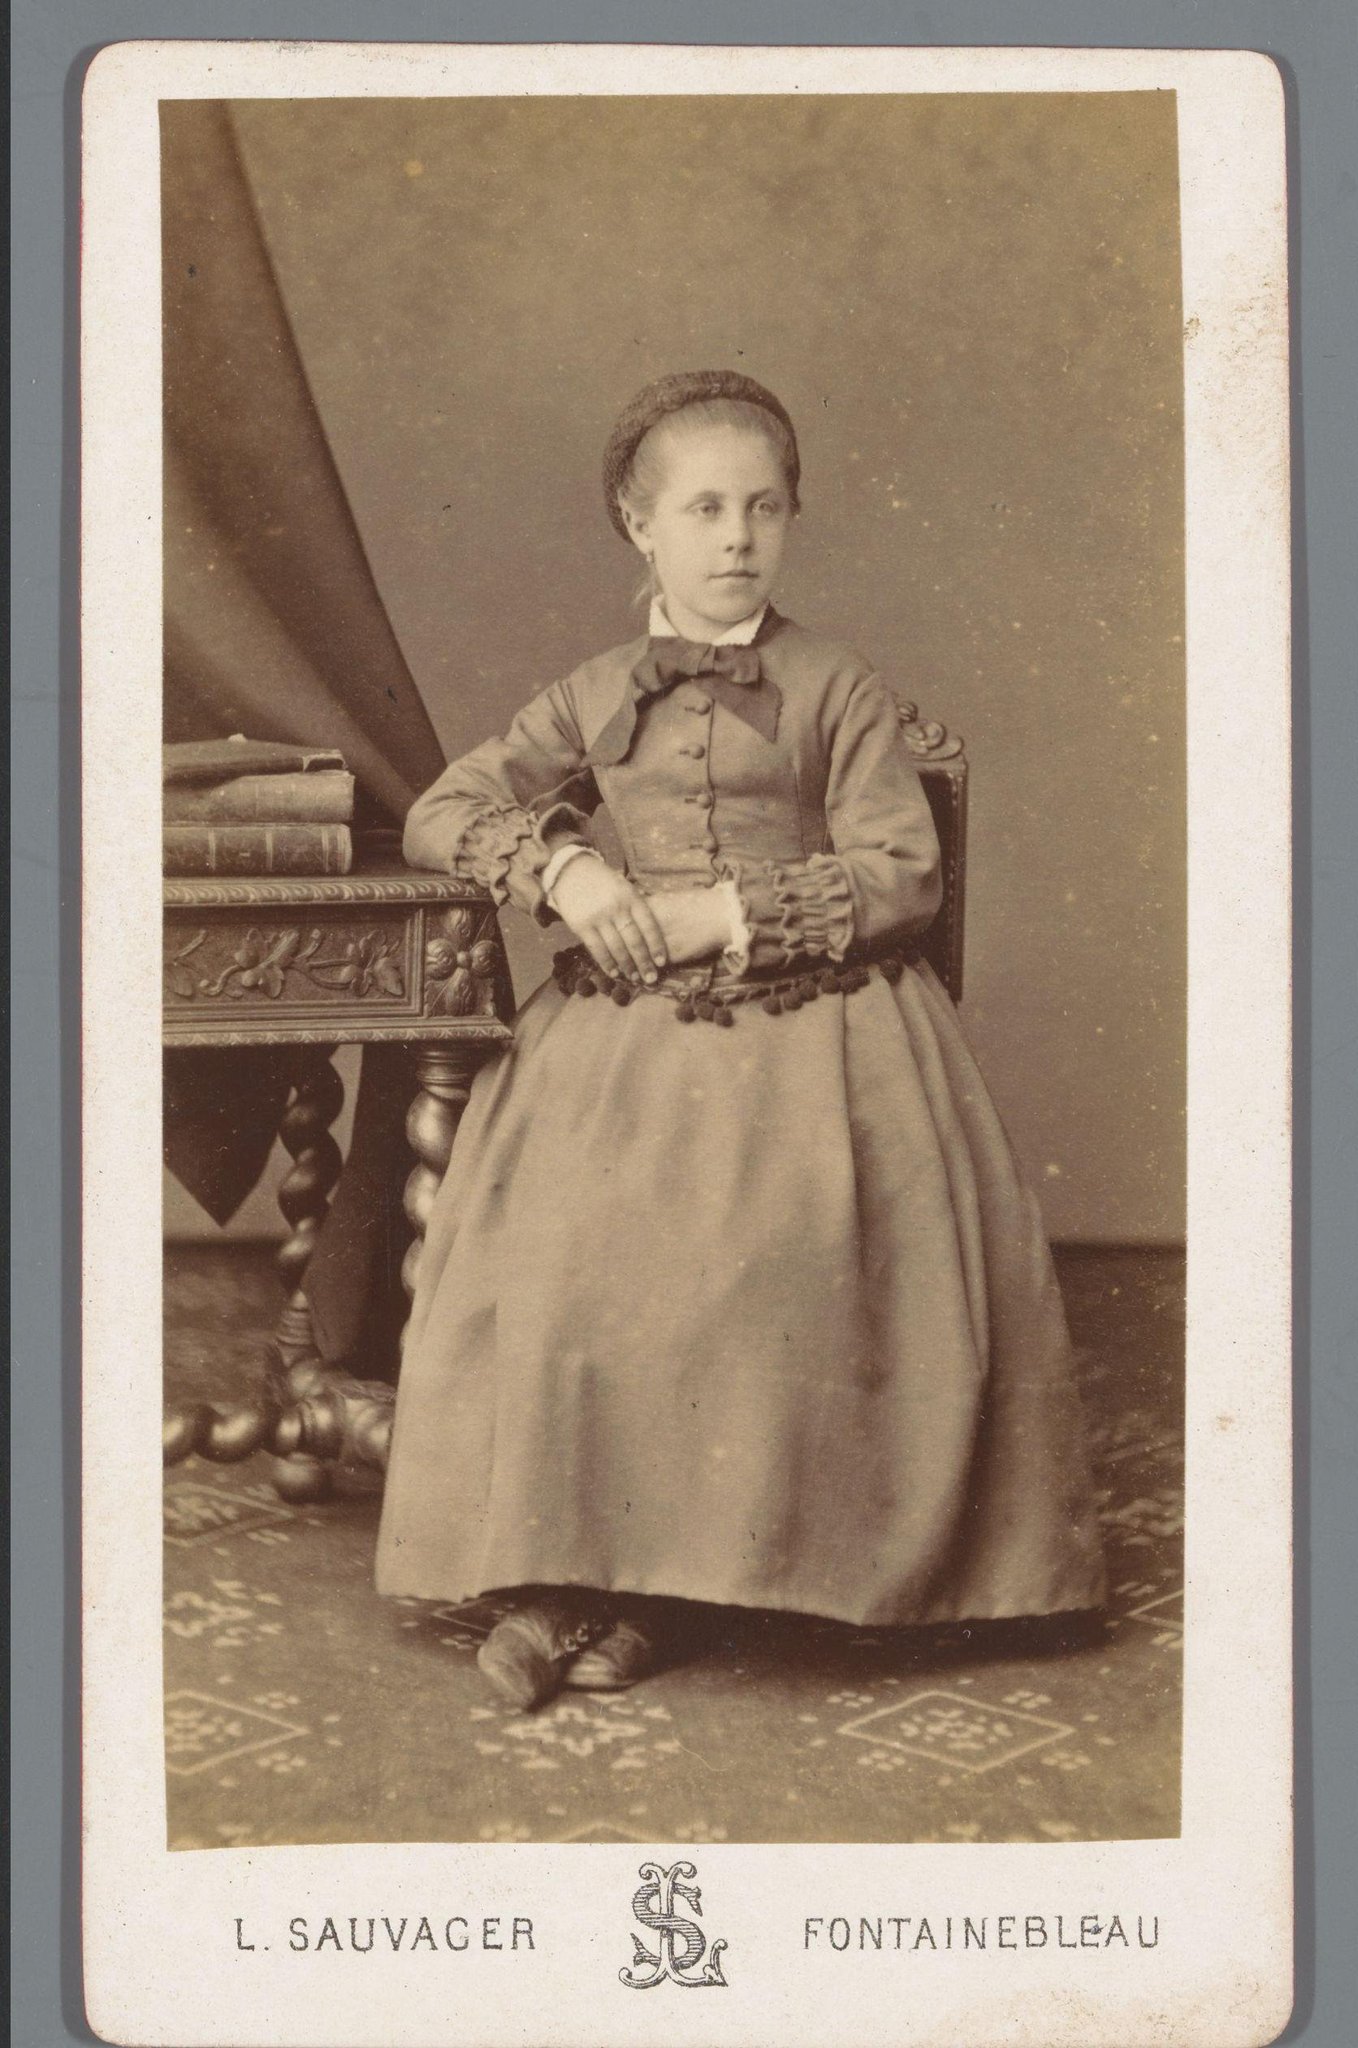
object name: photograph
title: Portret van een onbekende jonge vrouw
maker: louis sauvager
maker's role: fotograaf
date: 1855-1885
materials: cardboard, paper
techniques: albumen print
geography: fontainebleau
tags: adolescent, young woman, maiden, anonymous historical person portrayed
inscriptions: inscription: ‘L. Sauvager Fontainebleau’, monogram: ‘LS’, inscription: ‘Photographie hippique/ Fontainebleau/ Grande Rue, 201/ photographie/ L. Sauvager/ Nota: Tous les Clichés sont conservés./ Vues du palais et de la forêt.’